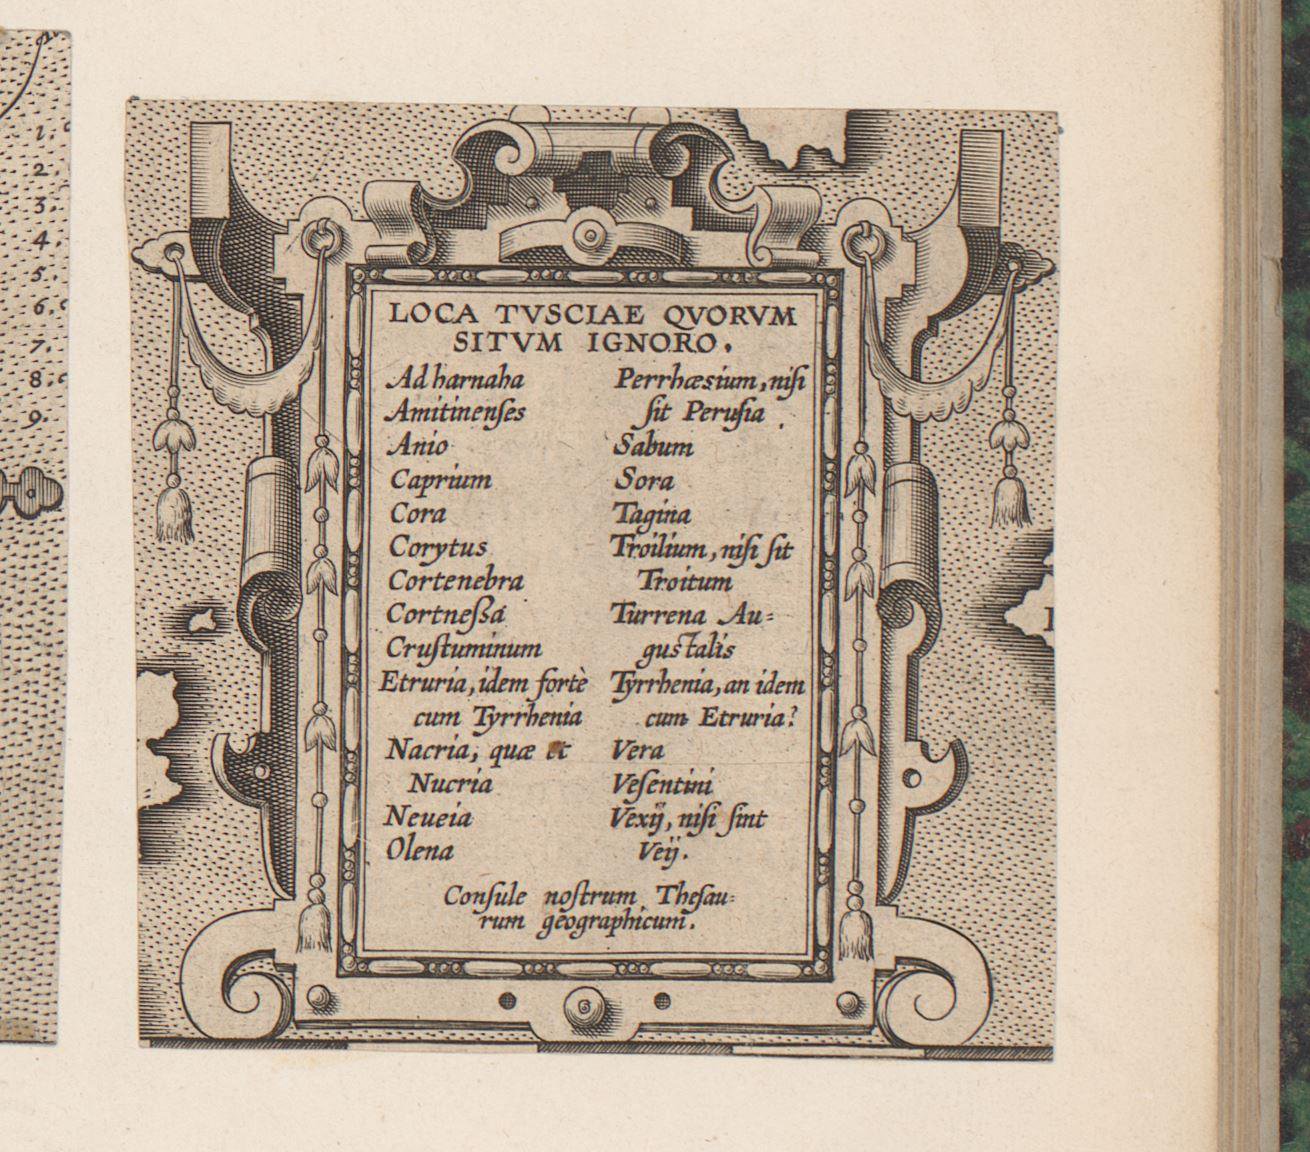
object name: album leaf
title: Theatrum Orbis Terrarum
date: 1595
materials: paper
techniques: engraving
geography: antwerp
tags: scrollwork, strapwork ~ ornament, ornament ~ cartouche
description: Rechthoekige rolwerkcartouche met namenlijst van onduidelijke plaatsen. De cartouche is een fragment van een kaart van Spanje. De prent maakt deel uit van een album.